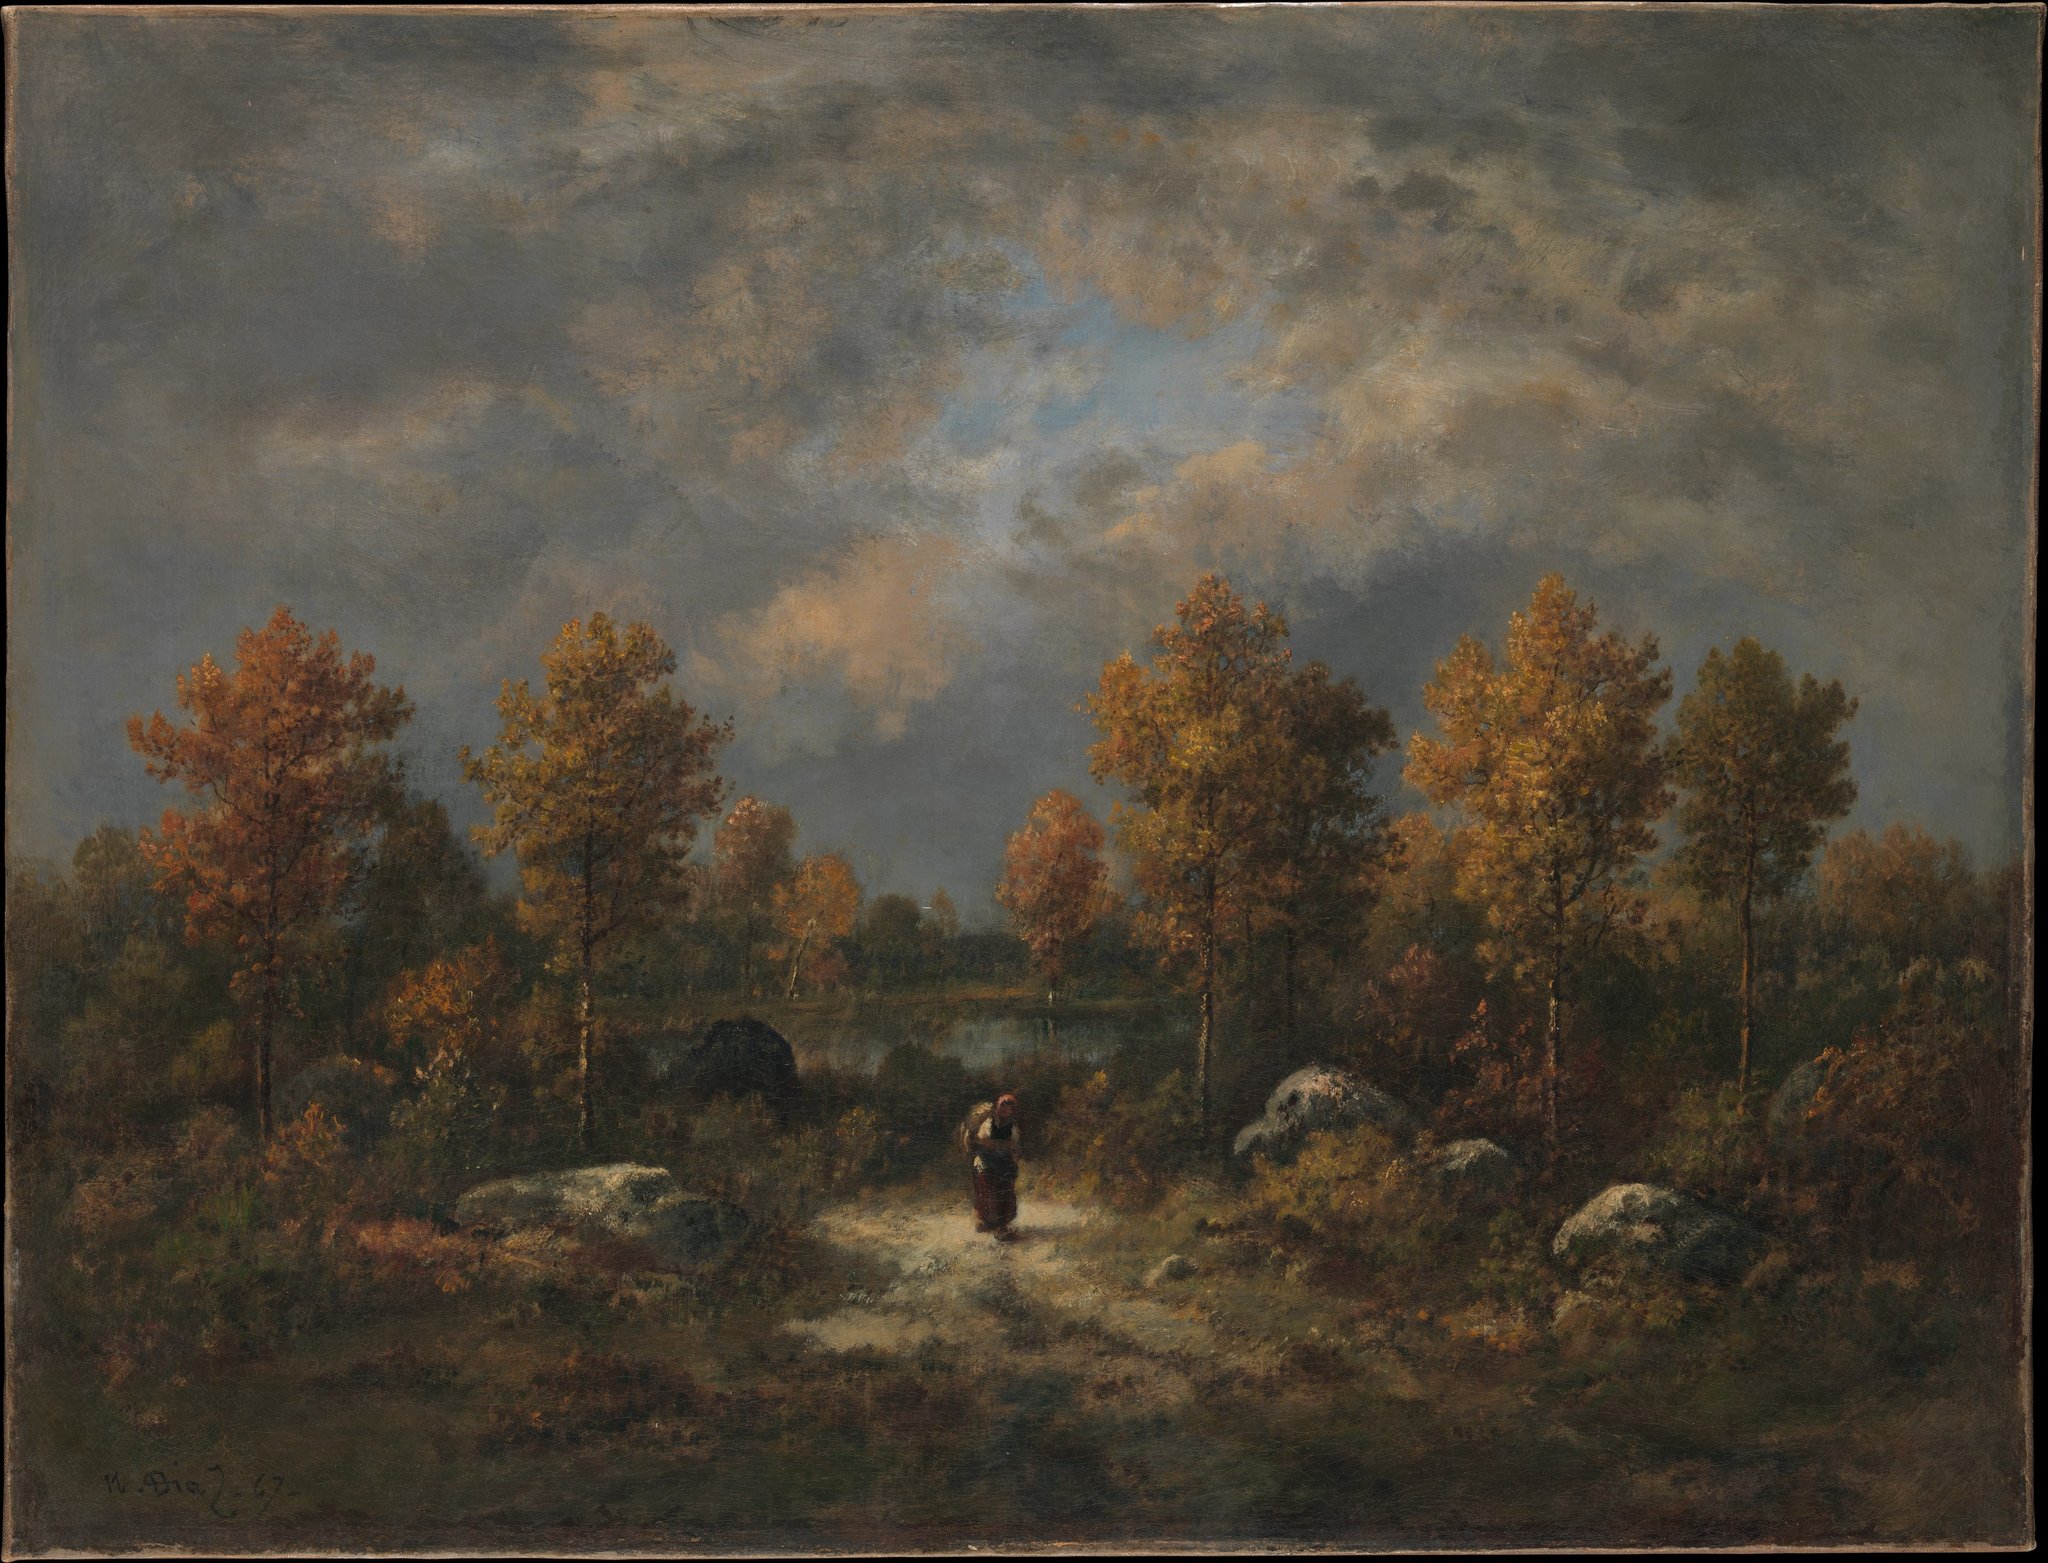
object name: painting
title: Autumn: The Woodland Pond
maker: narcisse-virgile diaz de la peña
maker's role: artist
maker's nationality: french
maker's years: 1808-1876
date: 1867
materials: canvas, oil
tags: forests,landscapes,autumn